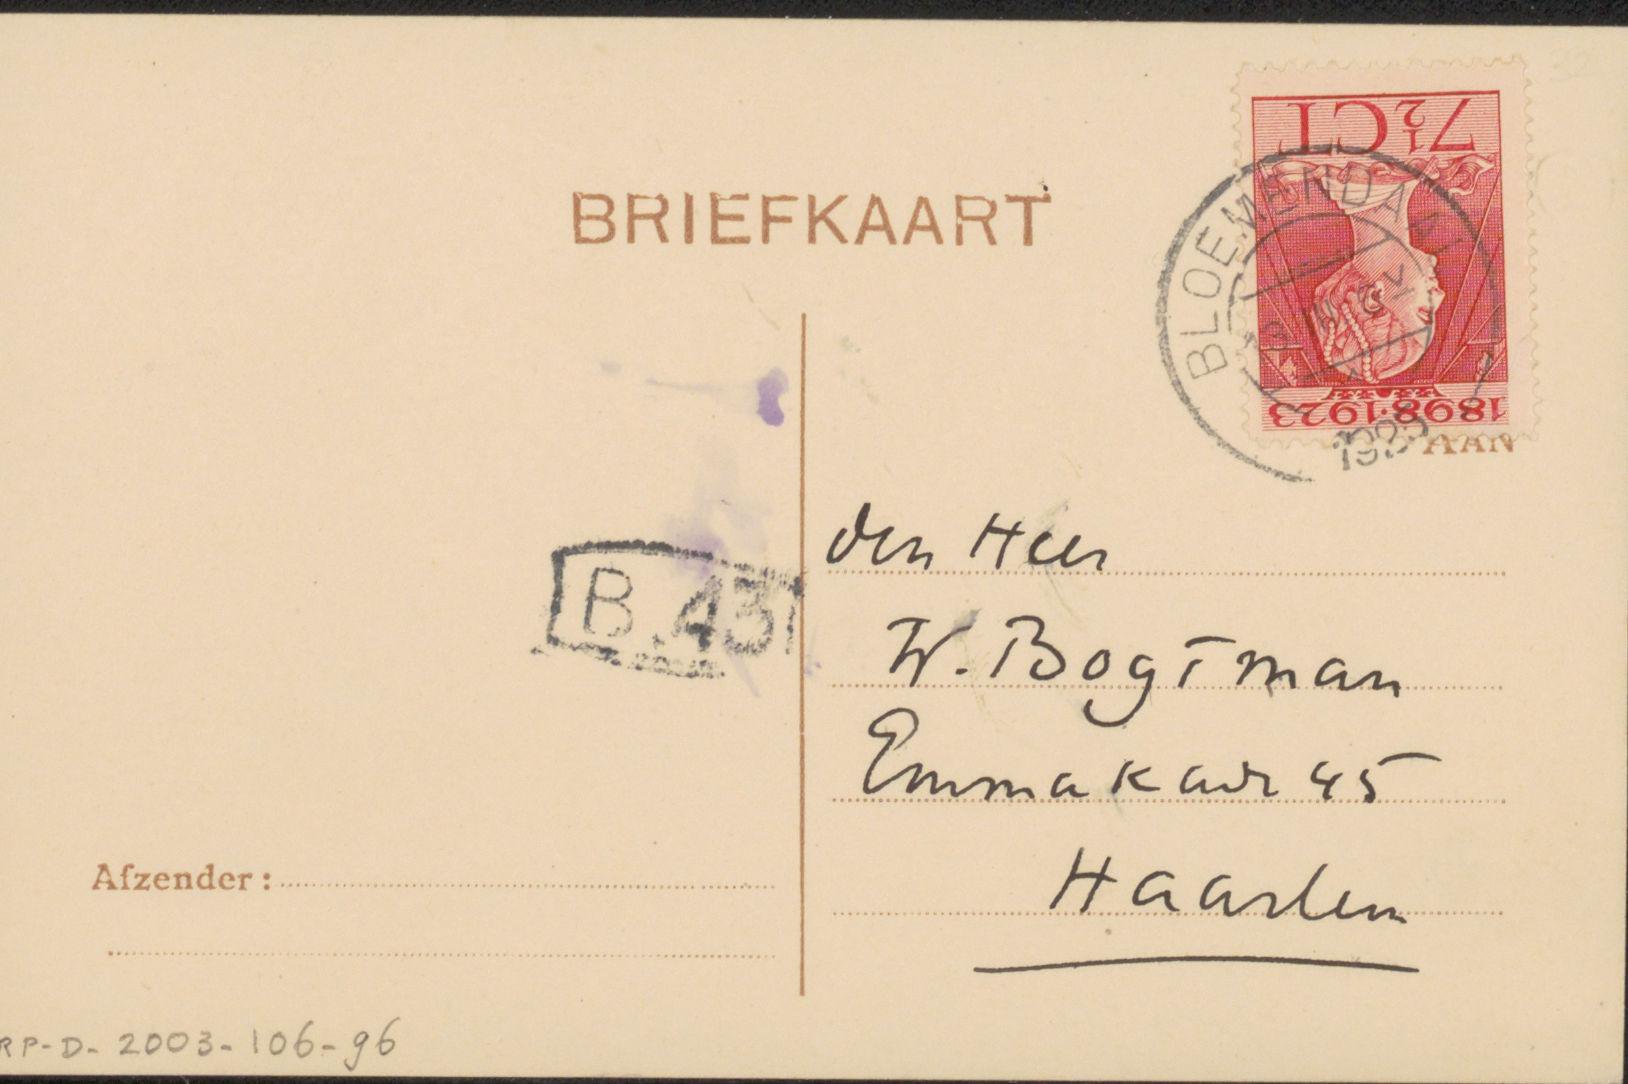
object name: postcard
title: Briefkaart aan Willem Bogtman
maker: richard nicolaüs roland holst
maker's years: 1868-1938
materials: cardboard, ink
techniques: pen, writing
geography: bloemendaal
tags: haarlem, willem bogtman, applied arts, arts and crafts; industrial design, exhibition ~ art, paris